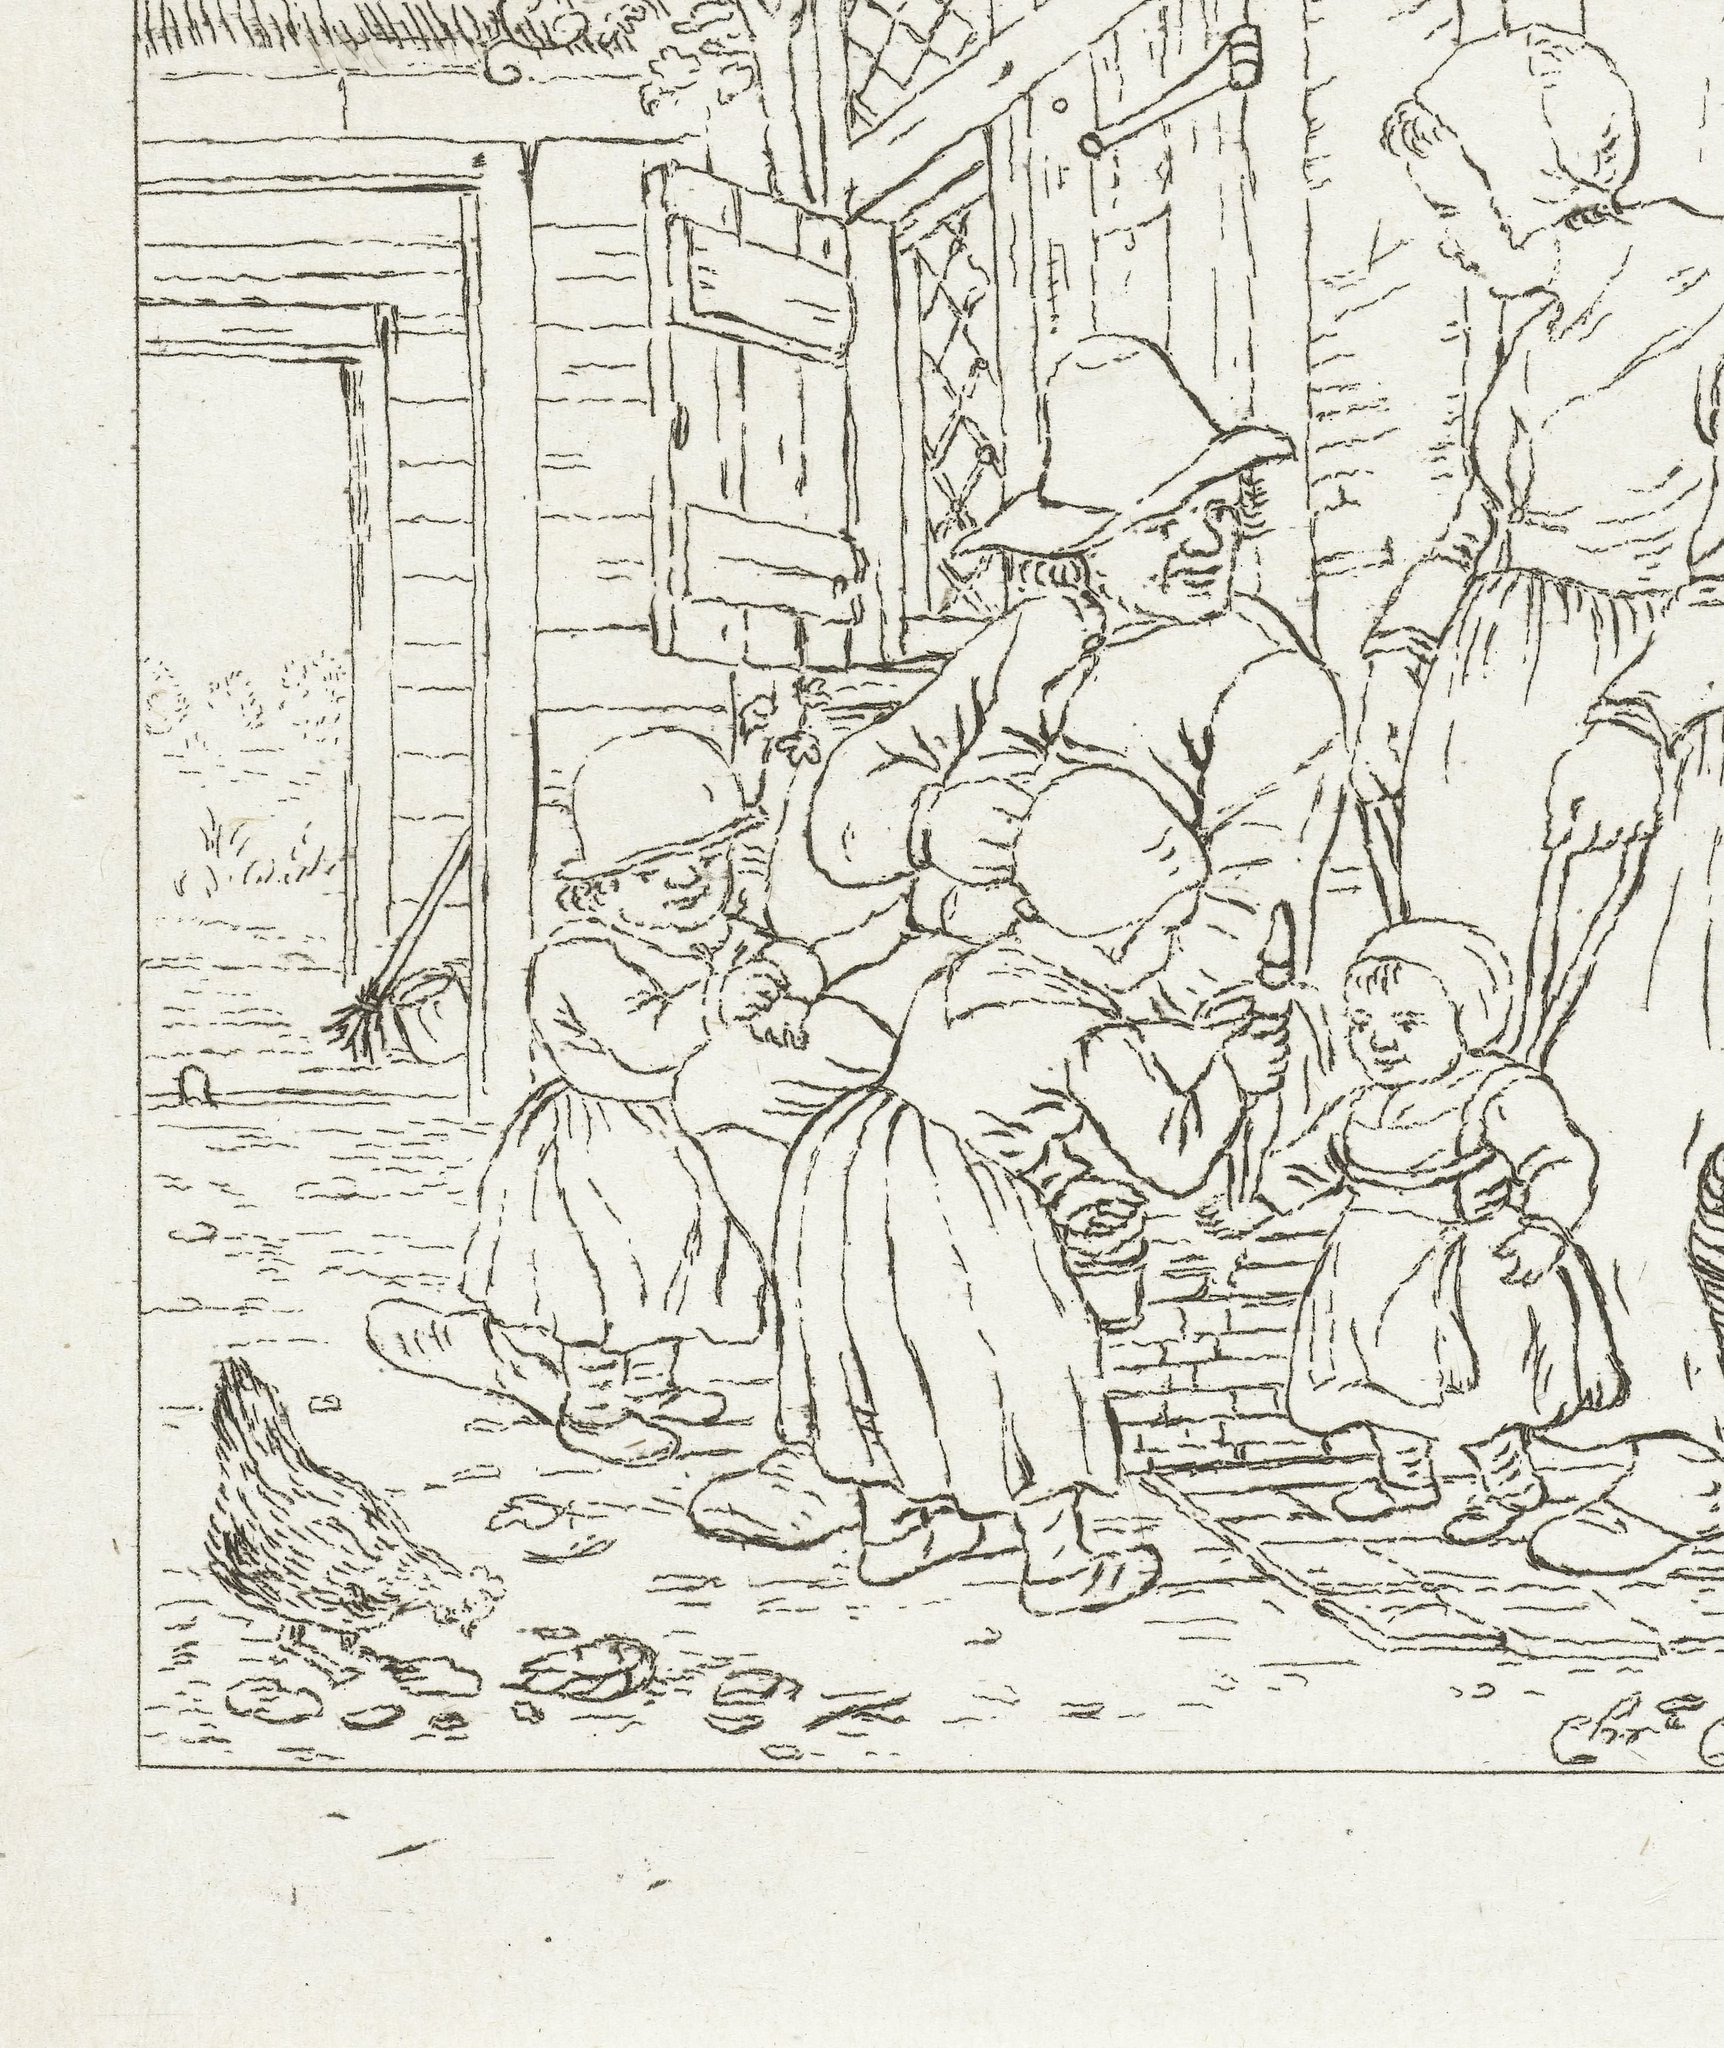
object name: print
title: Gezin voor een huis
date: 1779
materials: paper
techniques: etching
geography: leiden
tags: farmers, farmers - aa - female farmer, farmer's wife, fowl (cock, hen, chicken, etc.), mother and baby or young child, family group, especially parents with their child(ren) (with number of children)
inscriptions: collector's mark: Lugt 2233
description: Een boer zit voor zijn huis en speelt met zijn kinderen. Zijn vrouw komt naar buiten en brengt een van de kinderen mee. Het kind leert aan de leiband van haar moeder haar eerste pasjes zetten. Links in de hoek pikt een kip enkele graantjes weg.